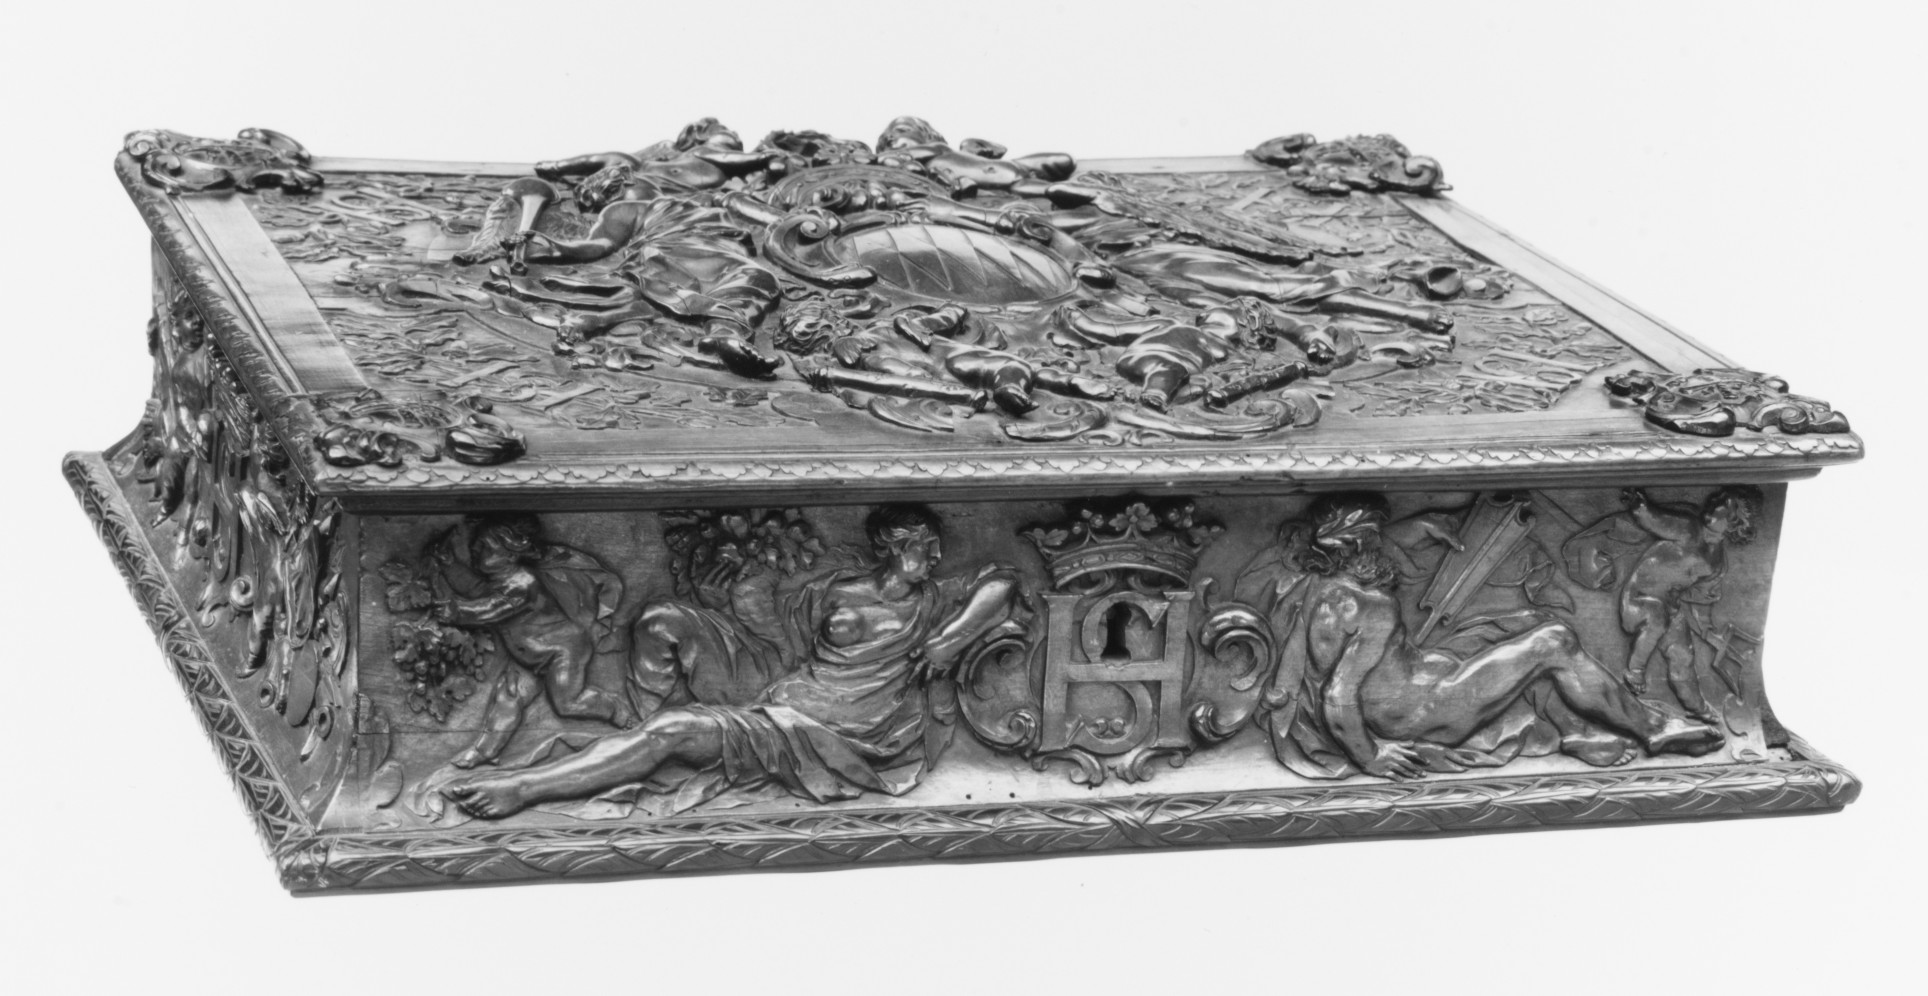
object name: box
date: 1651-1661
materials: wood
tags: male nudes,female nudes,cupid,coat of arms